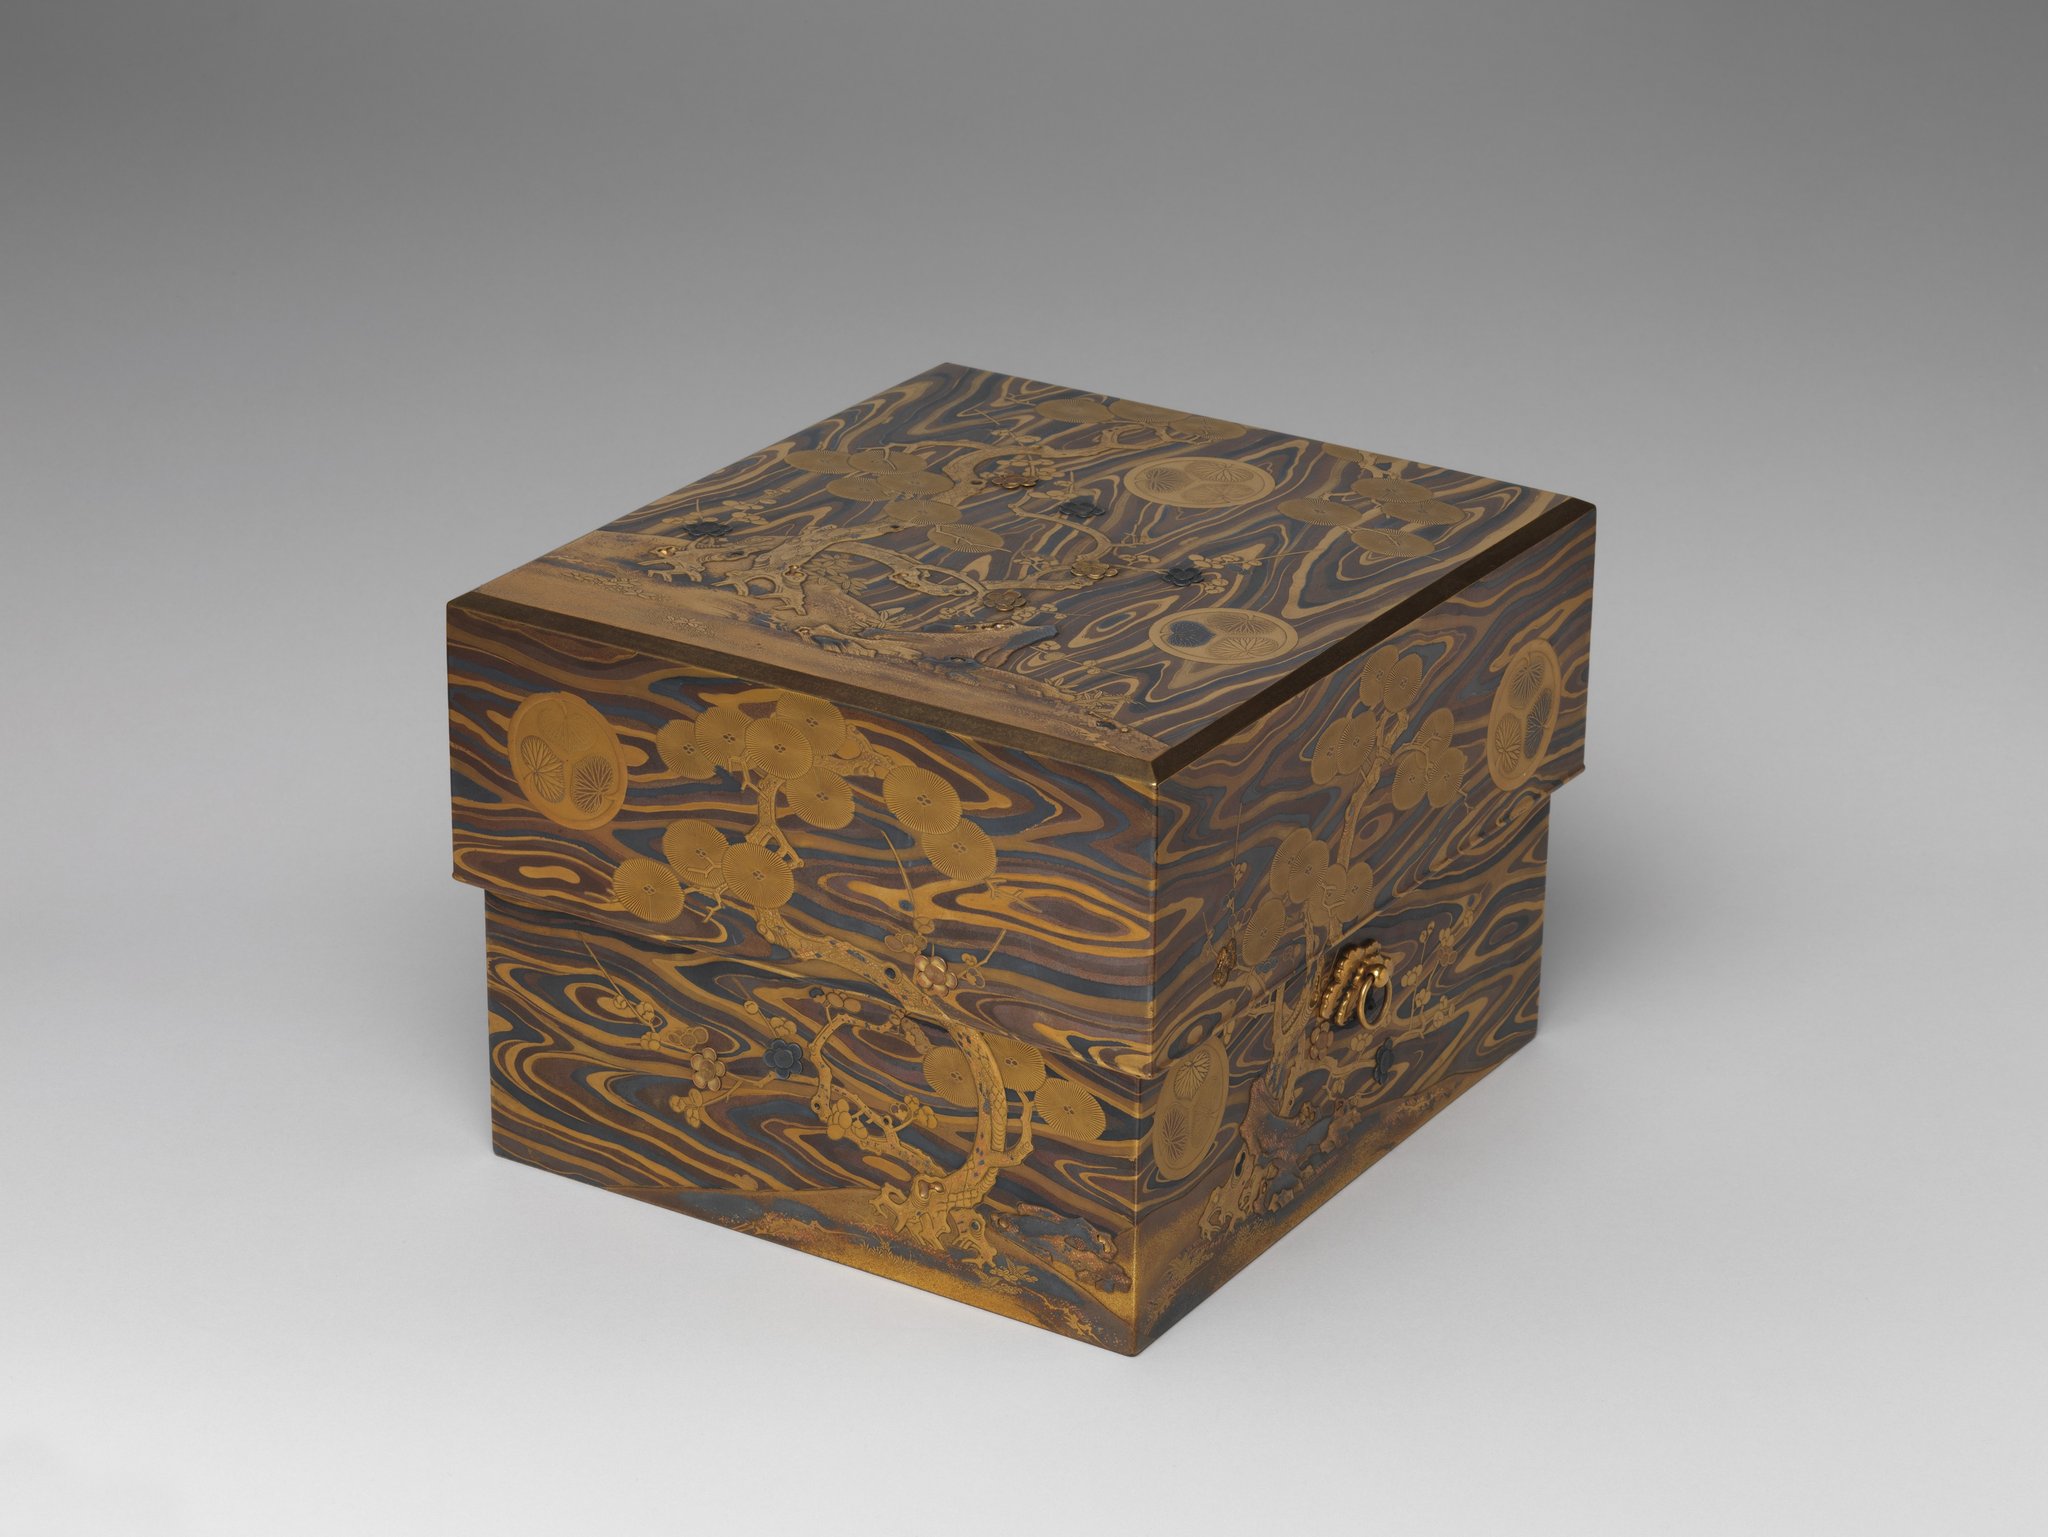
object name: box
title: Box for Hair Ornaments (motoyui-bako) with Pine, Bamboo, Plum, and Tokugawa Family Crest on Wood-Grain Ground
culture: japanese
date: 1701-1733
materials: foil, gold, lacquer, silver, wood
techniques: hiramakie, inlay, lacquer, maki-e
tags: trees